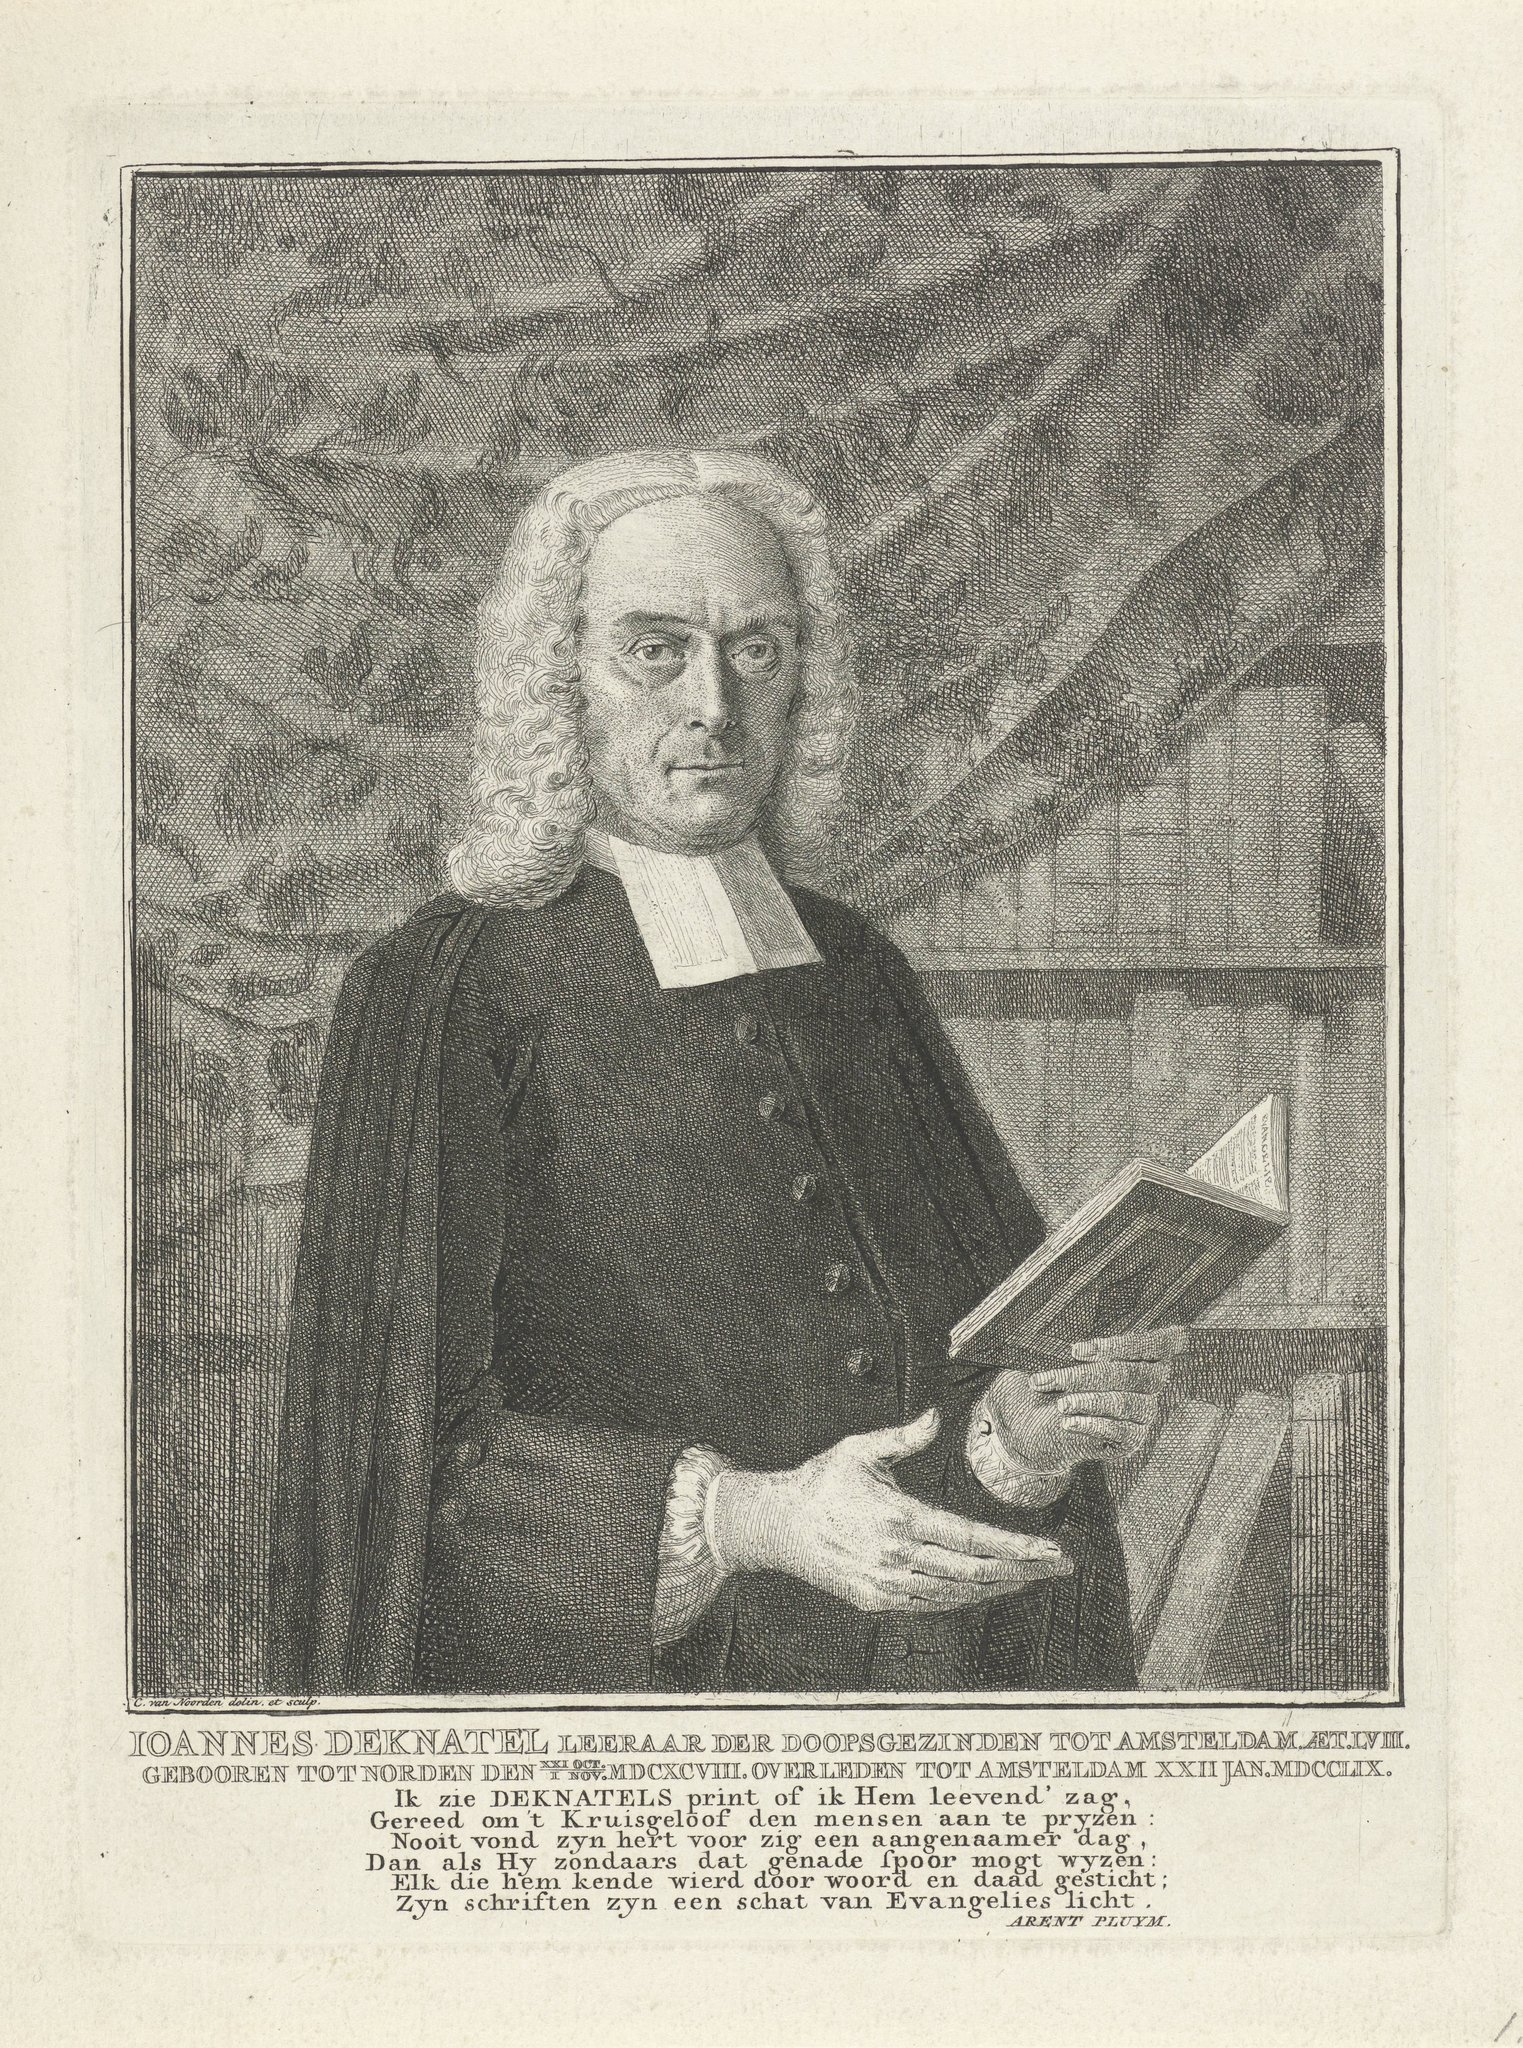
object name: print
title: Portret van Joannes Deknatel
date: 1759-1761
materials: paper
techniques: engraving, etching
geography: haarlem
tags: amsterdam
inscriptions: collector's mark: Lugt 2228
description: Portret van Joannes Deknatel, doopsgezind predikant te Amsterdam, op 58-jarige leeftijd.